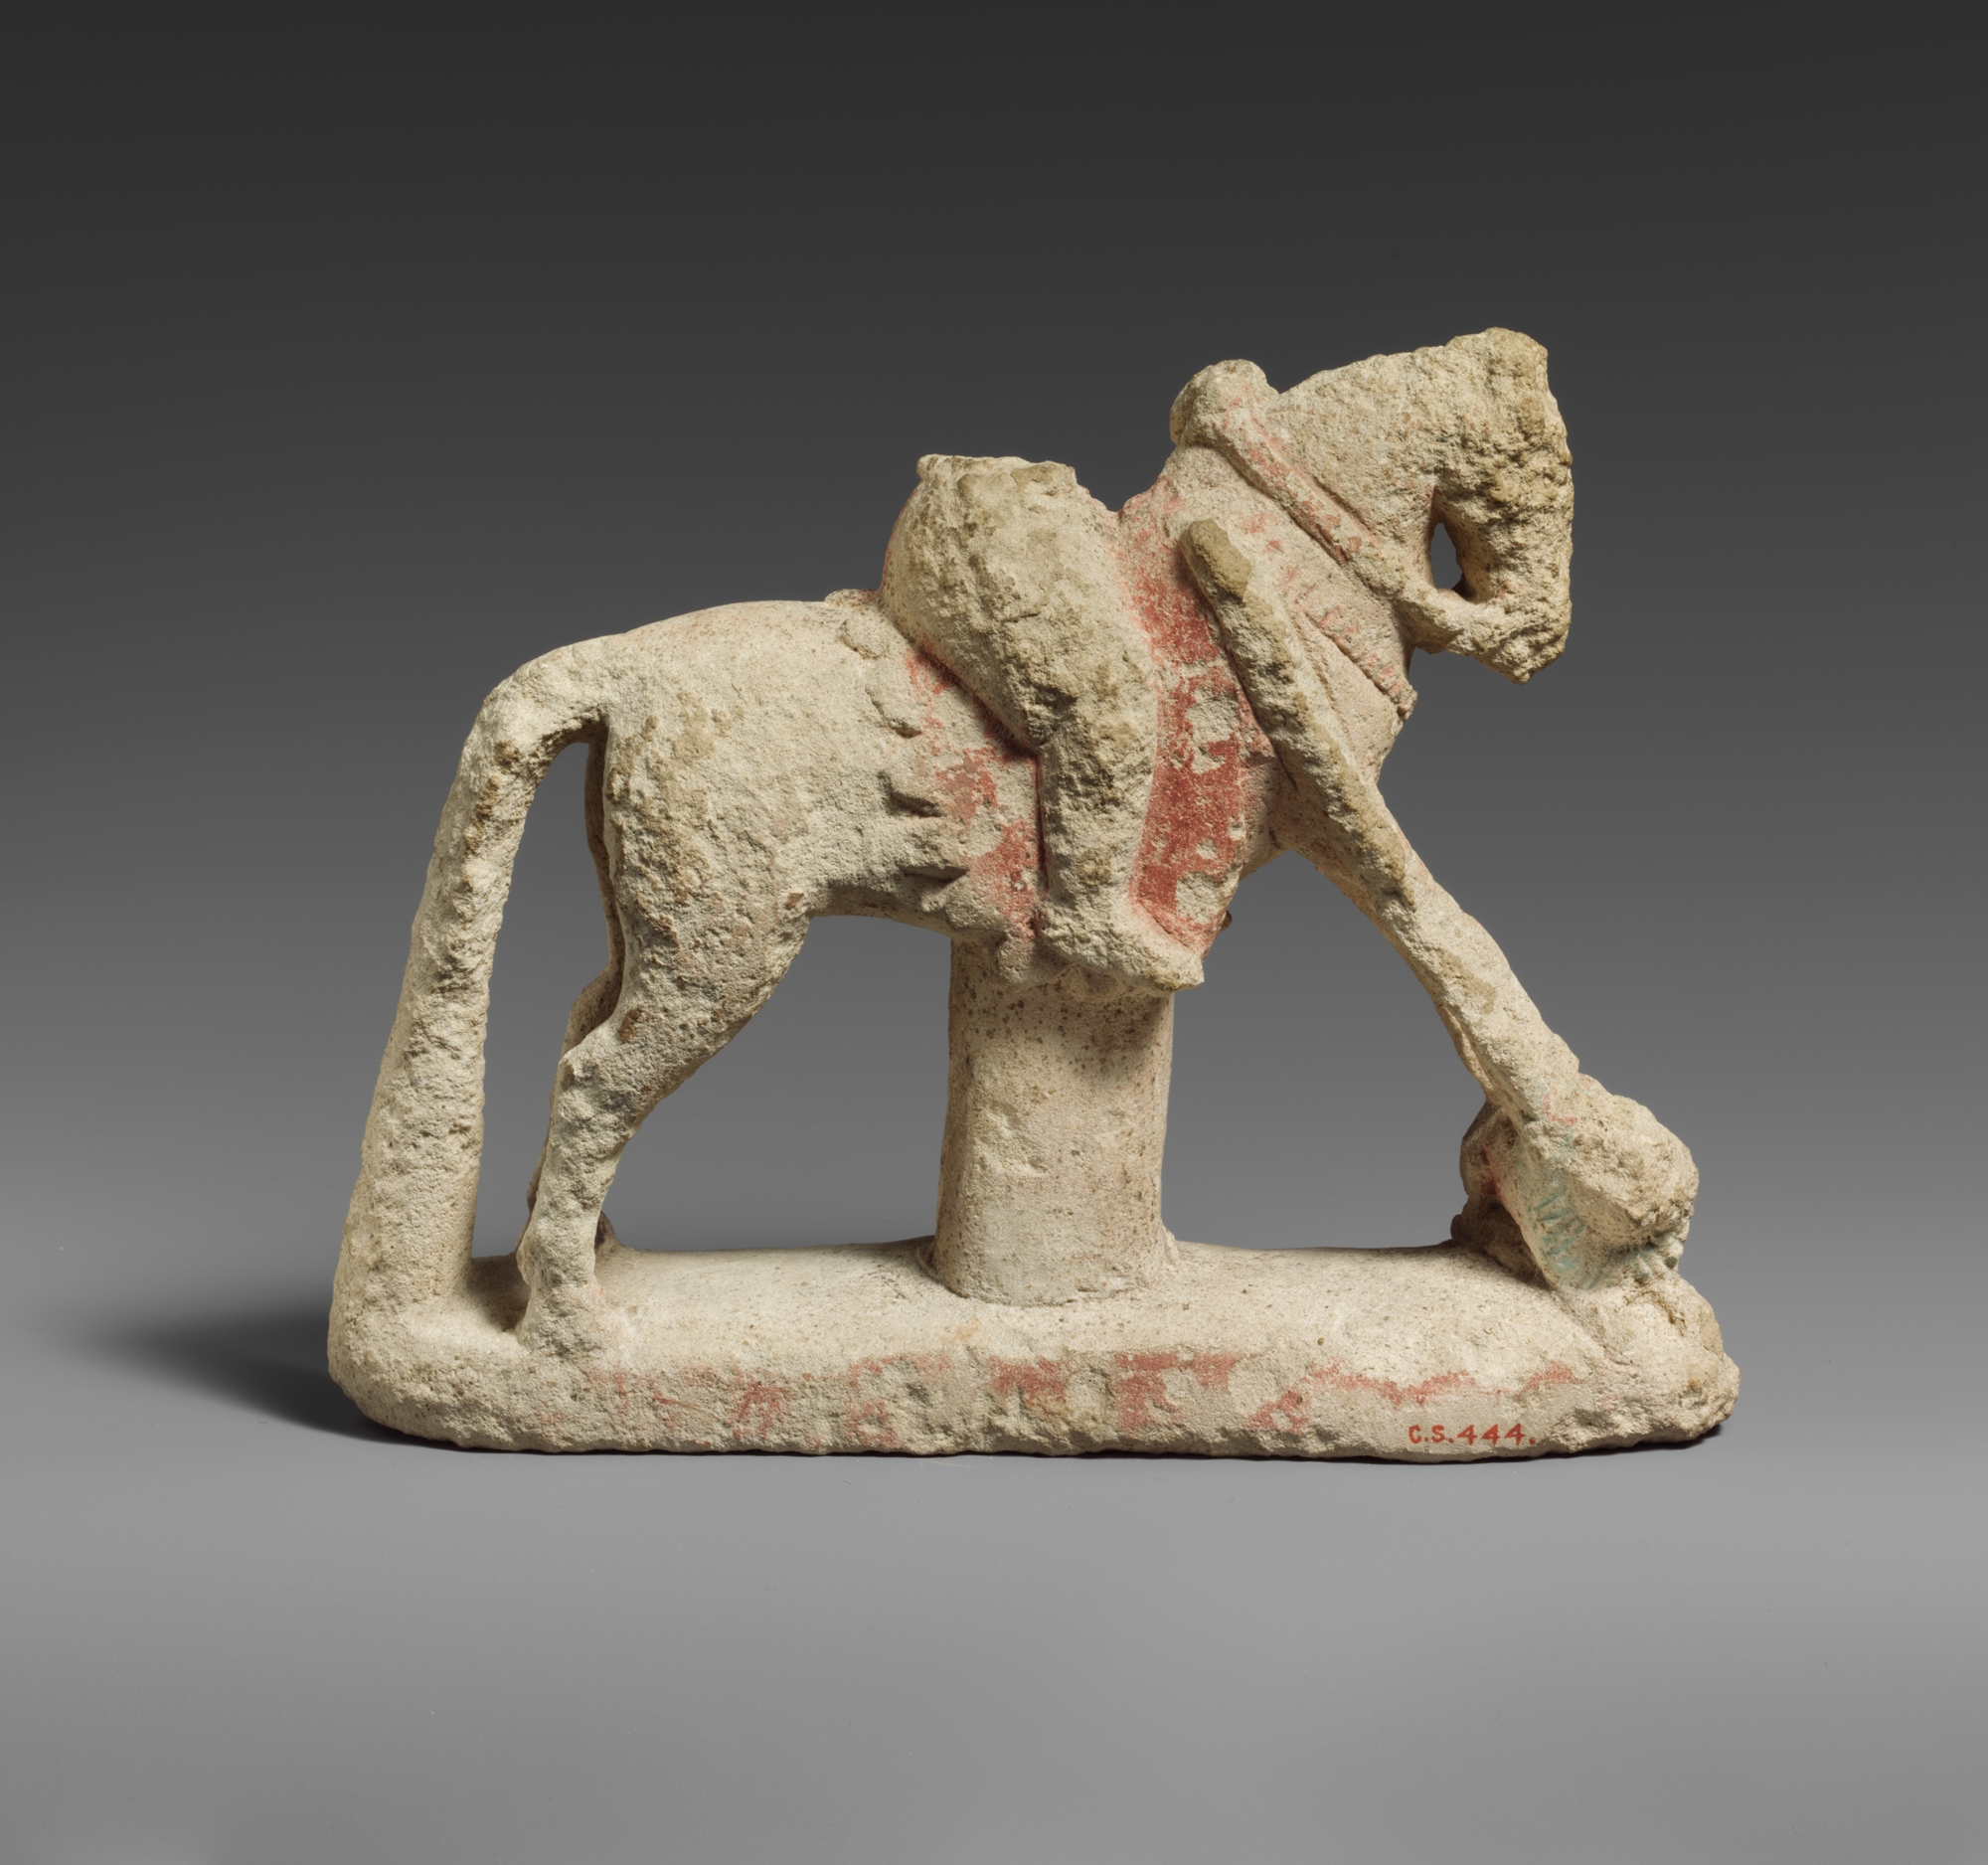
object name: statuette of a horse with rider and lion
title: Limestone horse with a rider hunting a lion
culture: cypriot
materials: limestone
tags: men,hunting,horses